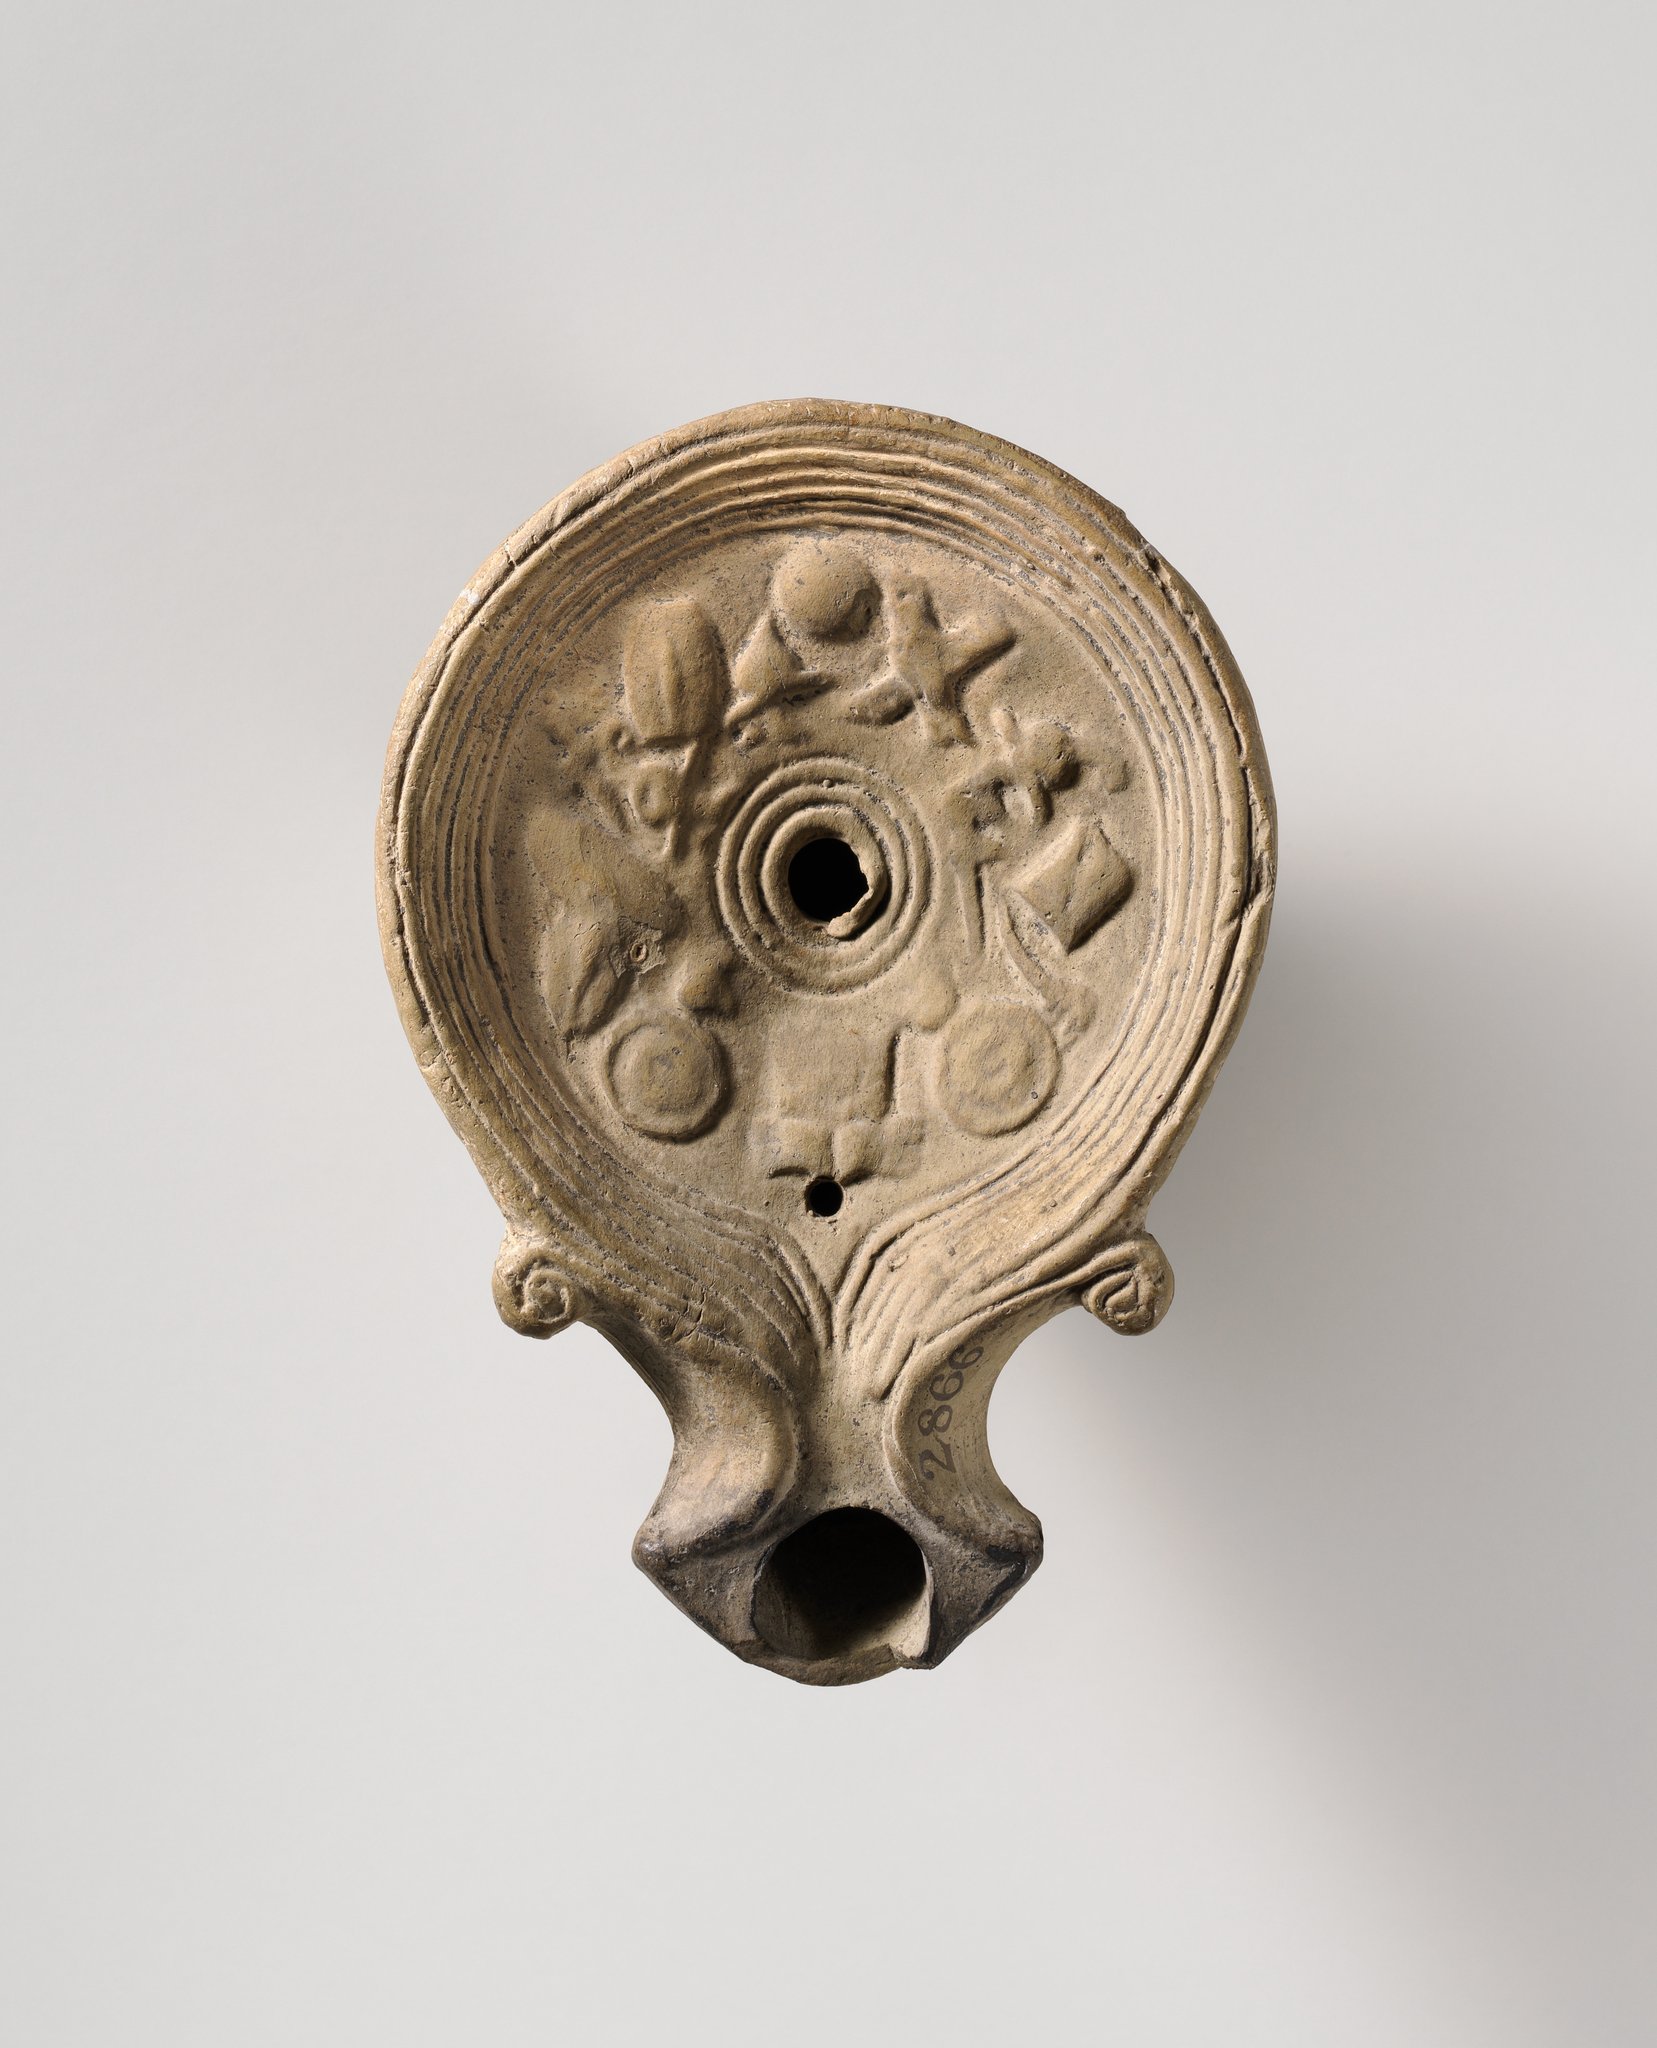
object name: lamp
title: Terracotta oil lamp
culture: roman, cypriot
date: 1-50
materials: terracotta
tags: helmets,shields